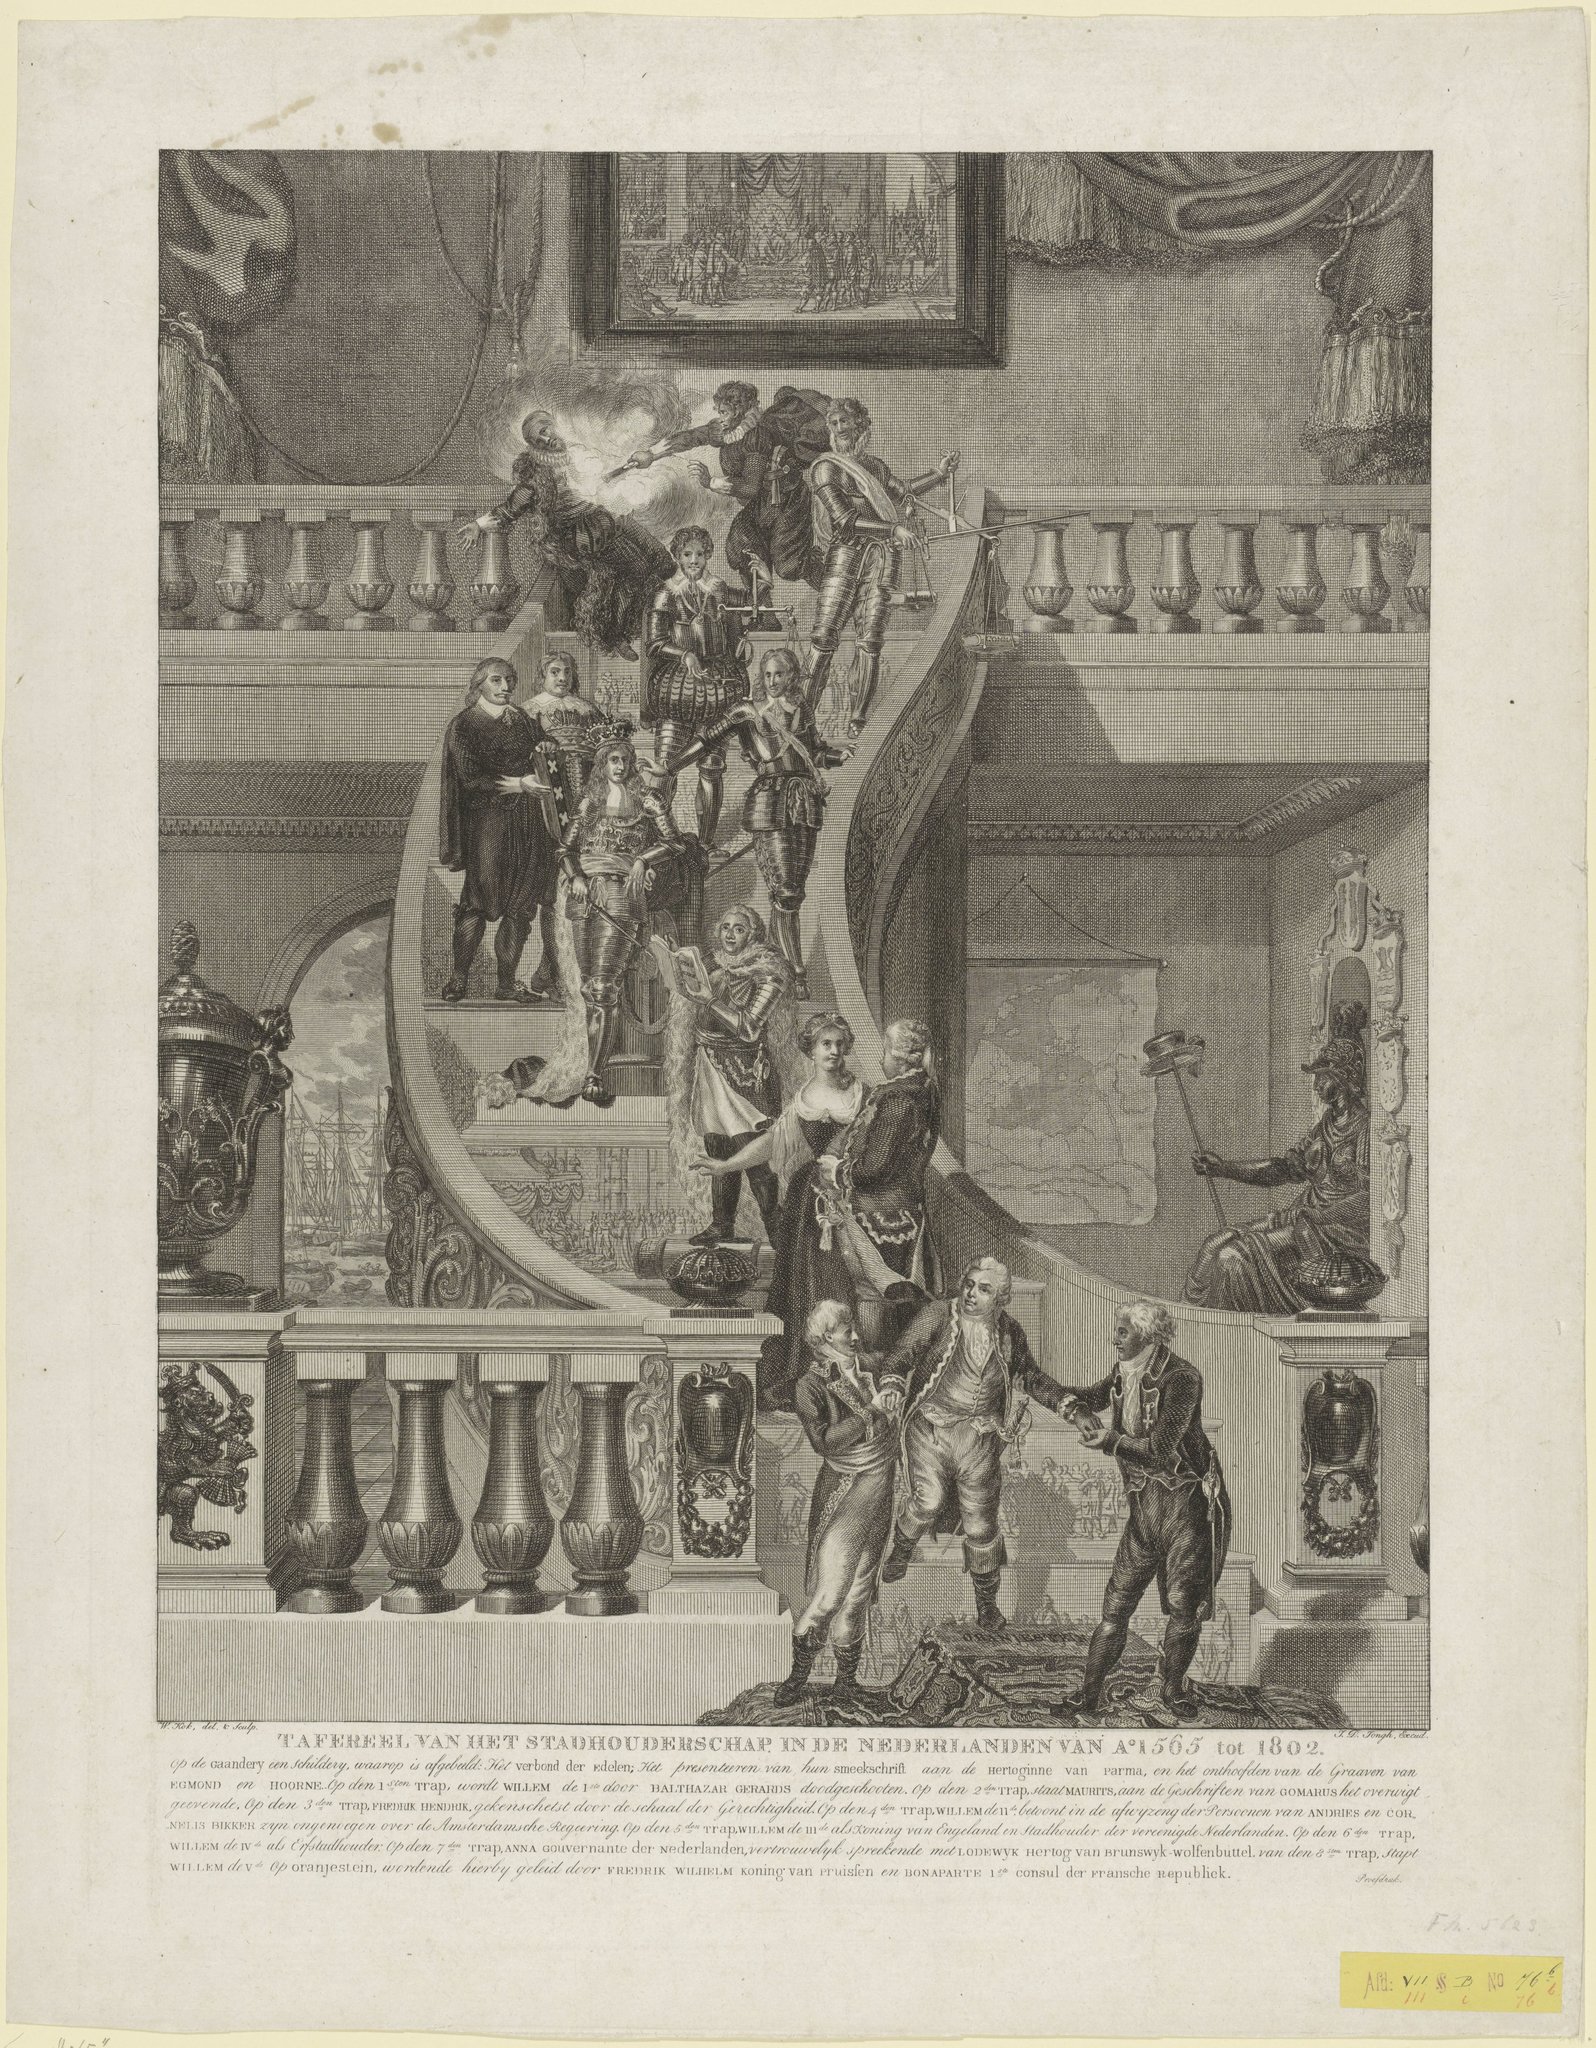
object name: print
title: Stadhouderschap tot 1802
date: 1802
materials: paper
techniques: engraving, etching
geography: amsterdam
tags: the hague, william v (prince of orange), ludwig ernst von braunschweig-wolfenbüttel, william iii (prince of orange and king of england, scotland, and ireland), frederick henry (prince of orange), william ii (prince of orange), delft, william i (prince of orange), maurice (prince of orange), amsterdam, mayor, willem iv (prins van oranje-nassau), anna van hannover, napoleon i (emperor of the french), berlin, frederik willem iii koning van pruisen, staircase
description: Overzicht van alle stadhouders in de Nederlanden, van Willem I tot en met Willem V. De stadhouders staan in chronologische volgorde op de treden van een grote trap in een paleis. Bovenaan Willem I die vermoord wordt door Balthasar Gerards. Daarna Maurits, Frederik Hendrik, Willem II met Andries en Cornelis Bicker als vertegenwoordigers van Amsterdam, Willem III en Willem IV. Na Willem IV volgen de voogden van Willem V: Anna en Lodewijk Ernst. Onderaan stapt tenslotte Willem V als laatste van de stadhouders van de trap af op een steen gemerkt Oranienstein, verwijzend naar Slot Oranienstein in Duitsland waarheen Willem vertrok, na het erkennen van de Bataafse Republiek als onderdeel van bepalingen van de Vrede van Amiens, op 27 maart 1802. Hierbij wordt hij geholpen door Napoleon I en Frederik Willem III. In het onderschrift een verklaring van de voorstelling in zes regels. Rechtsonder 'Proefdruk.'.